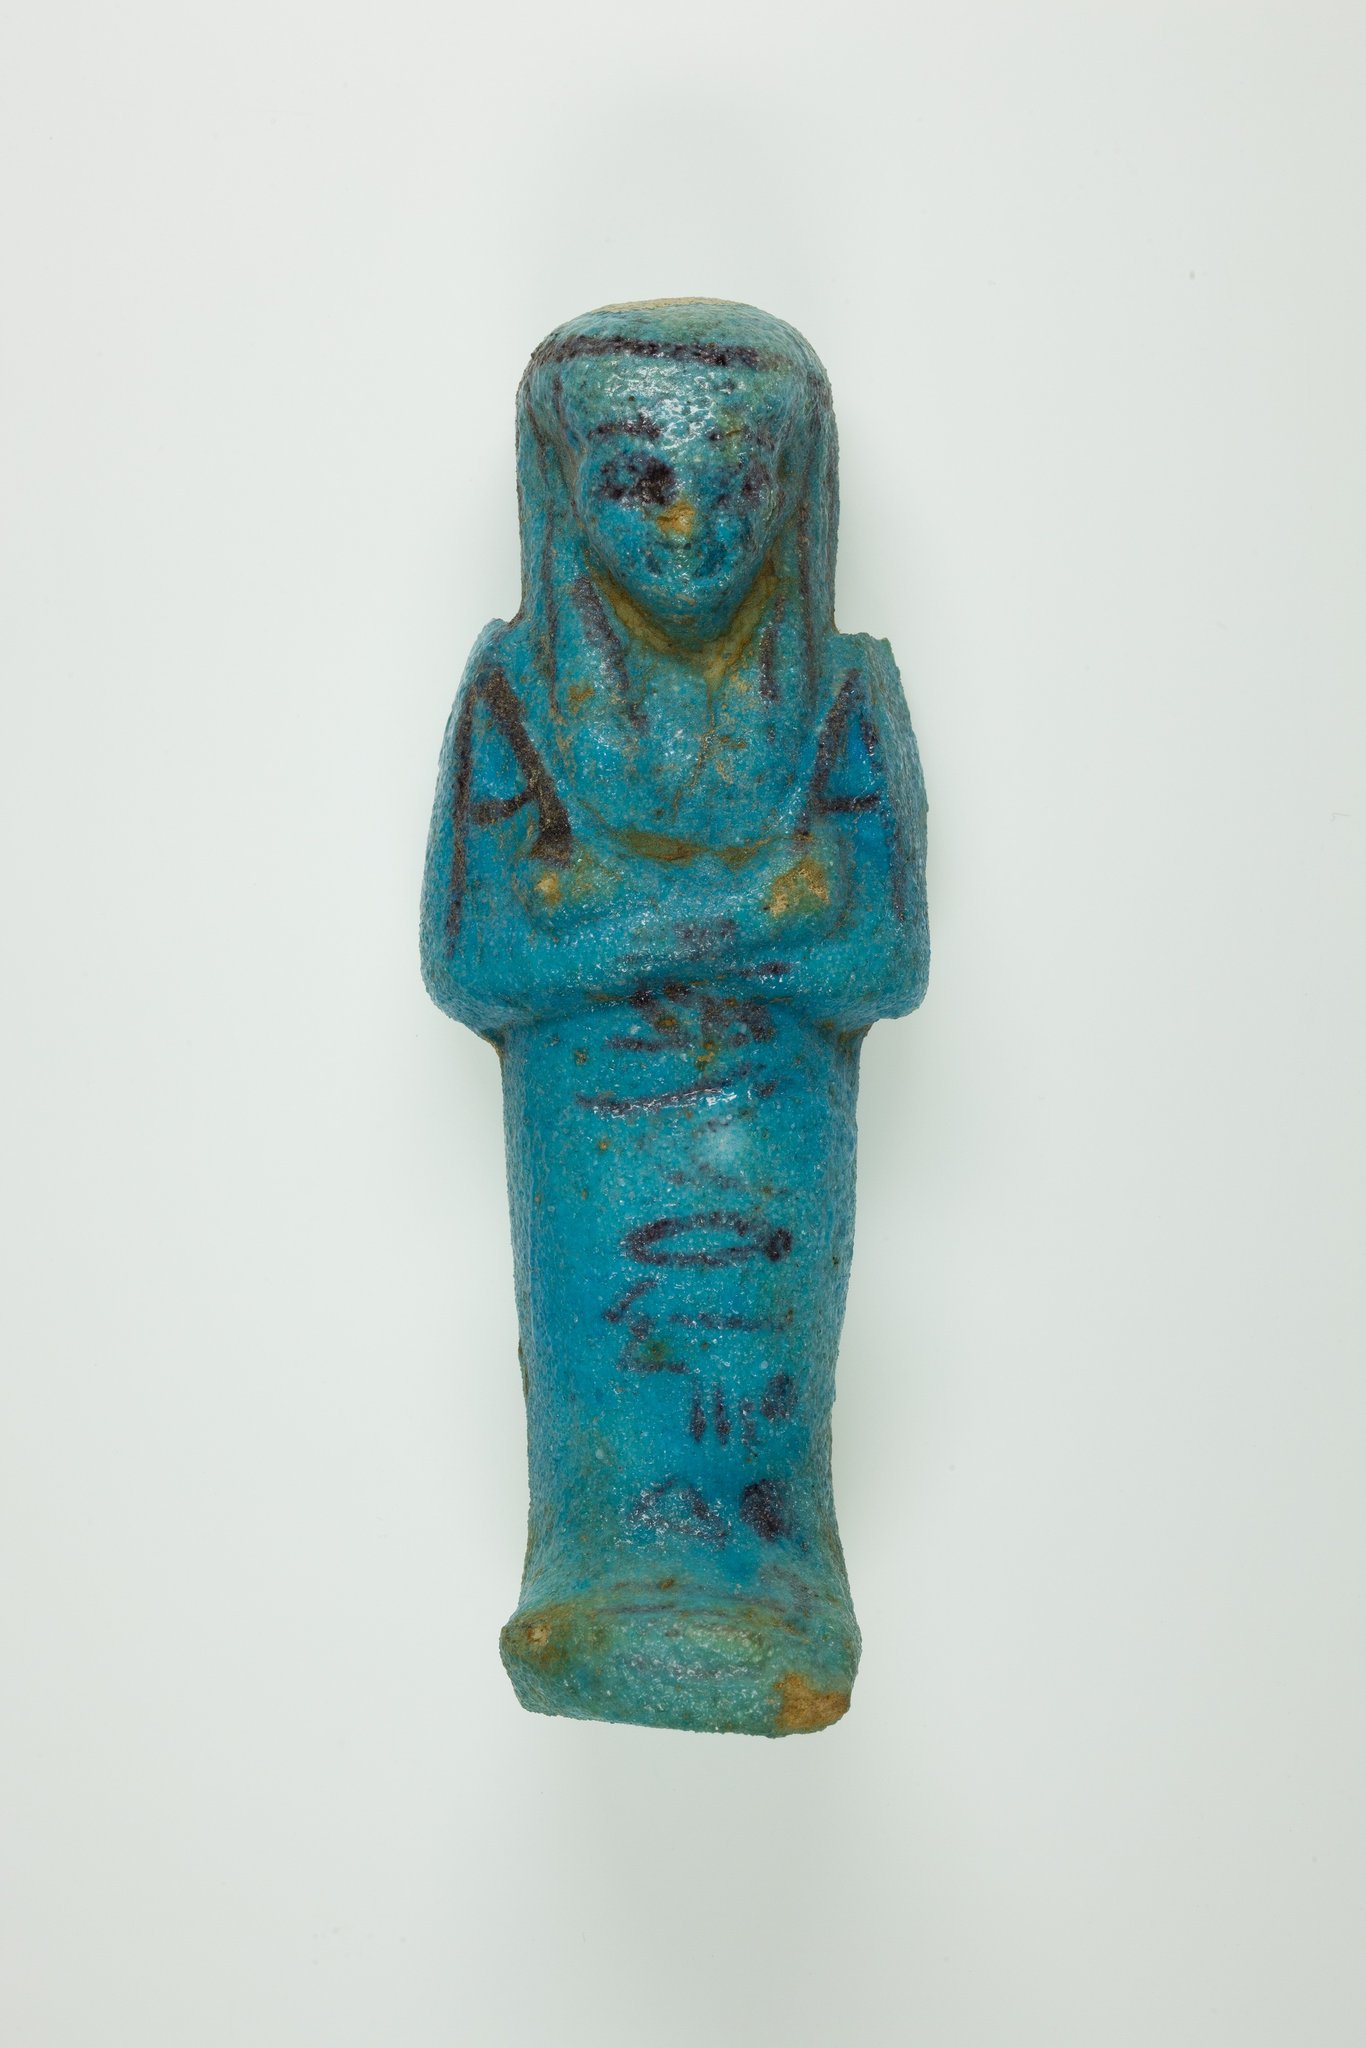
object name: worker shabti, henettawy c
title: Worker Shabti of Henettawy (C), Daughter of Isetemkheb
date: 990-970 BCE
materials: faience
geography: egypt